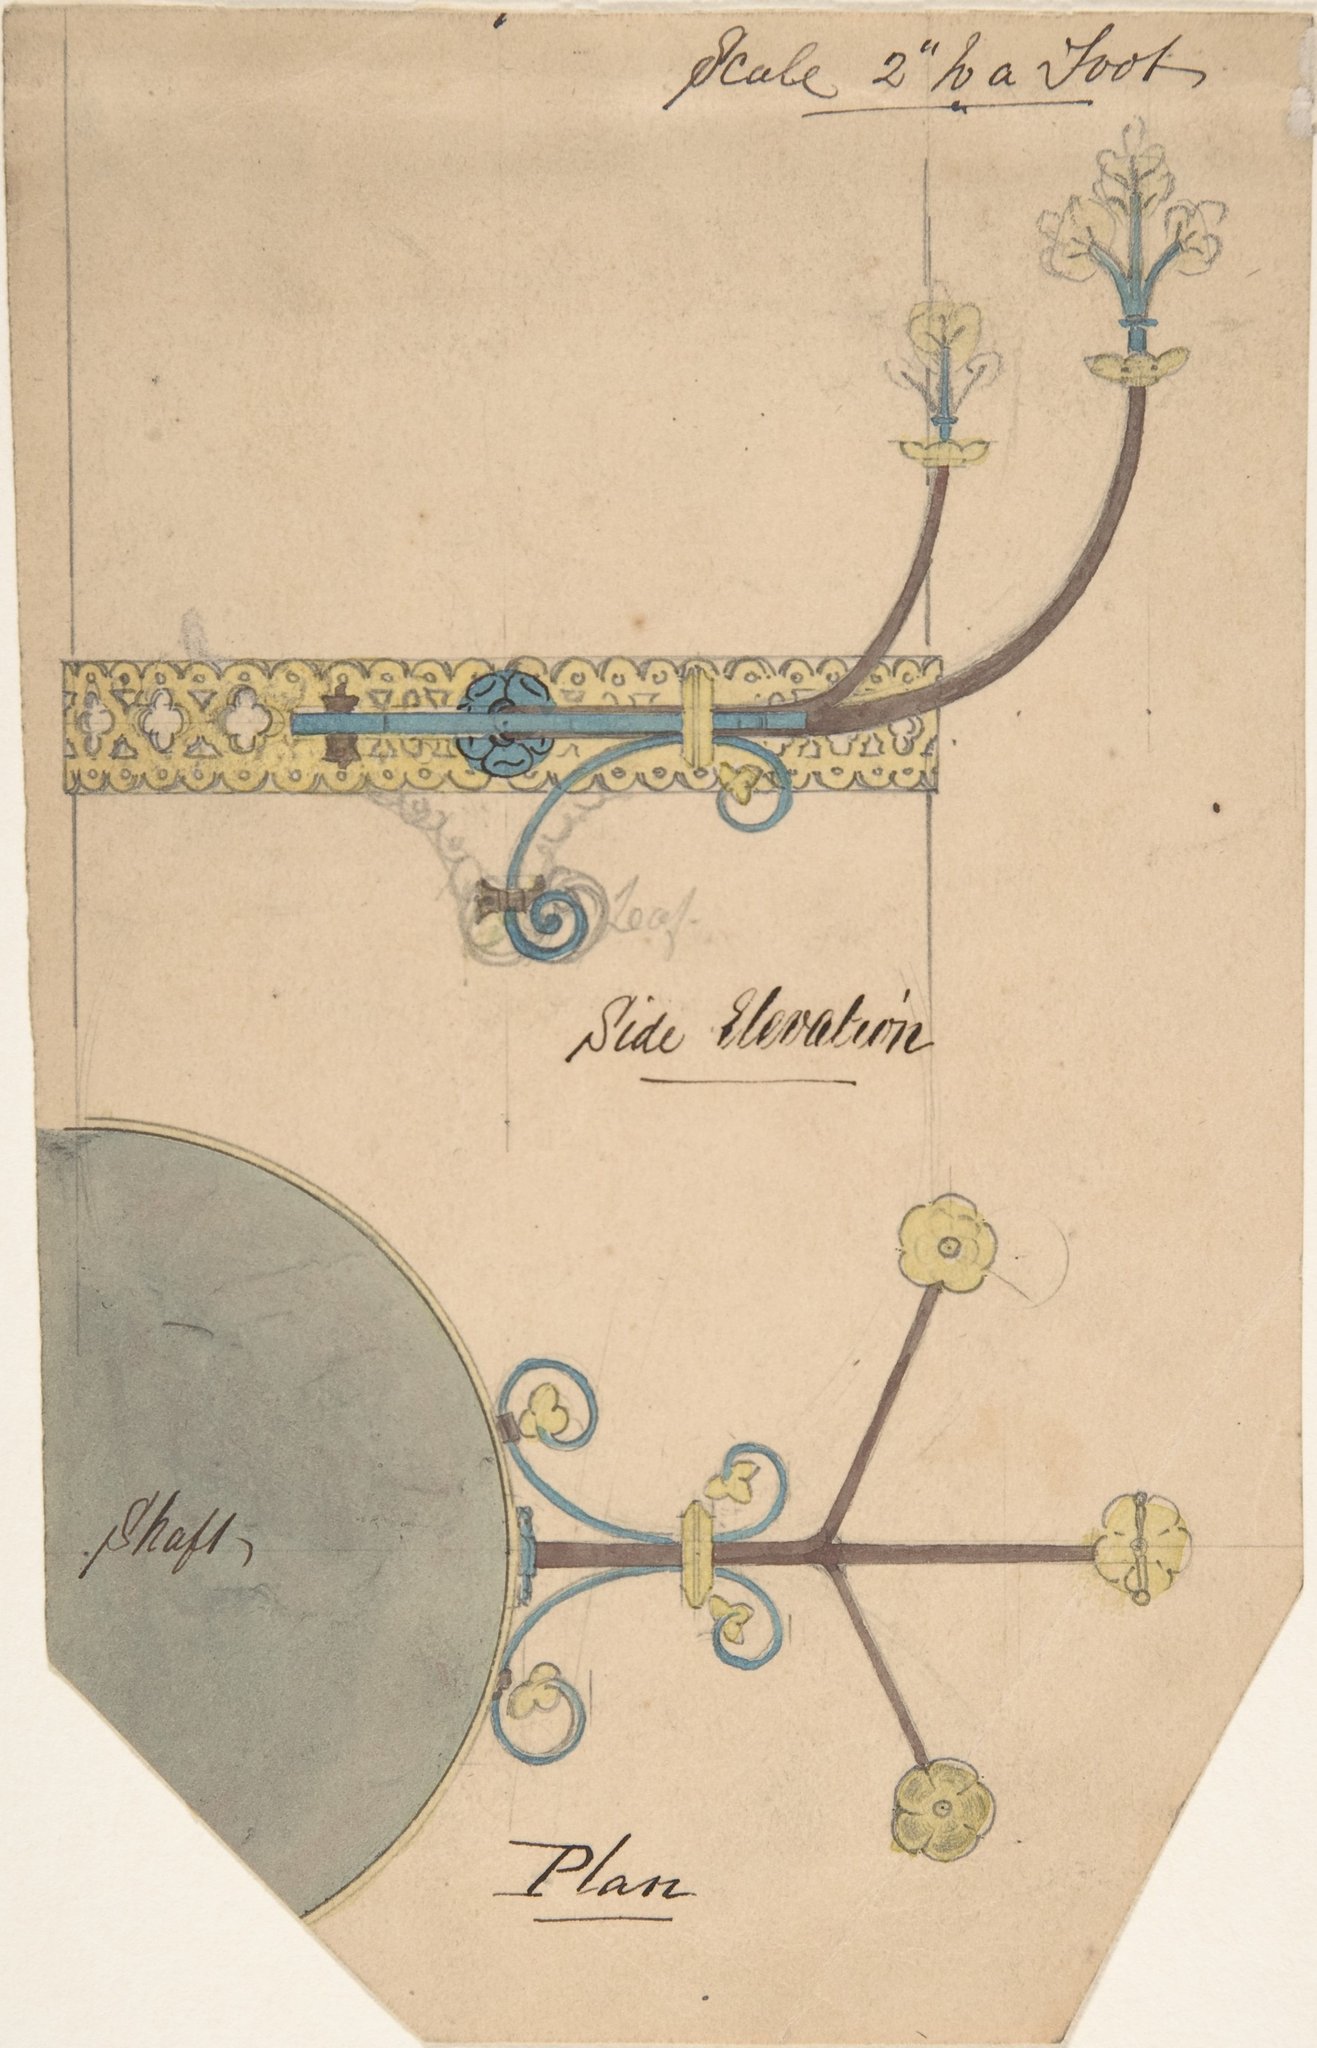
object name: drawing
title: Design for Floral Brackets for a Church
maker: richardson ellson & co.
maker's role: artist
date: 1880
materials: ink, watercolor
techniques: brush, pen, wash